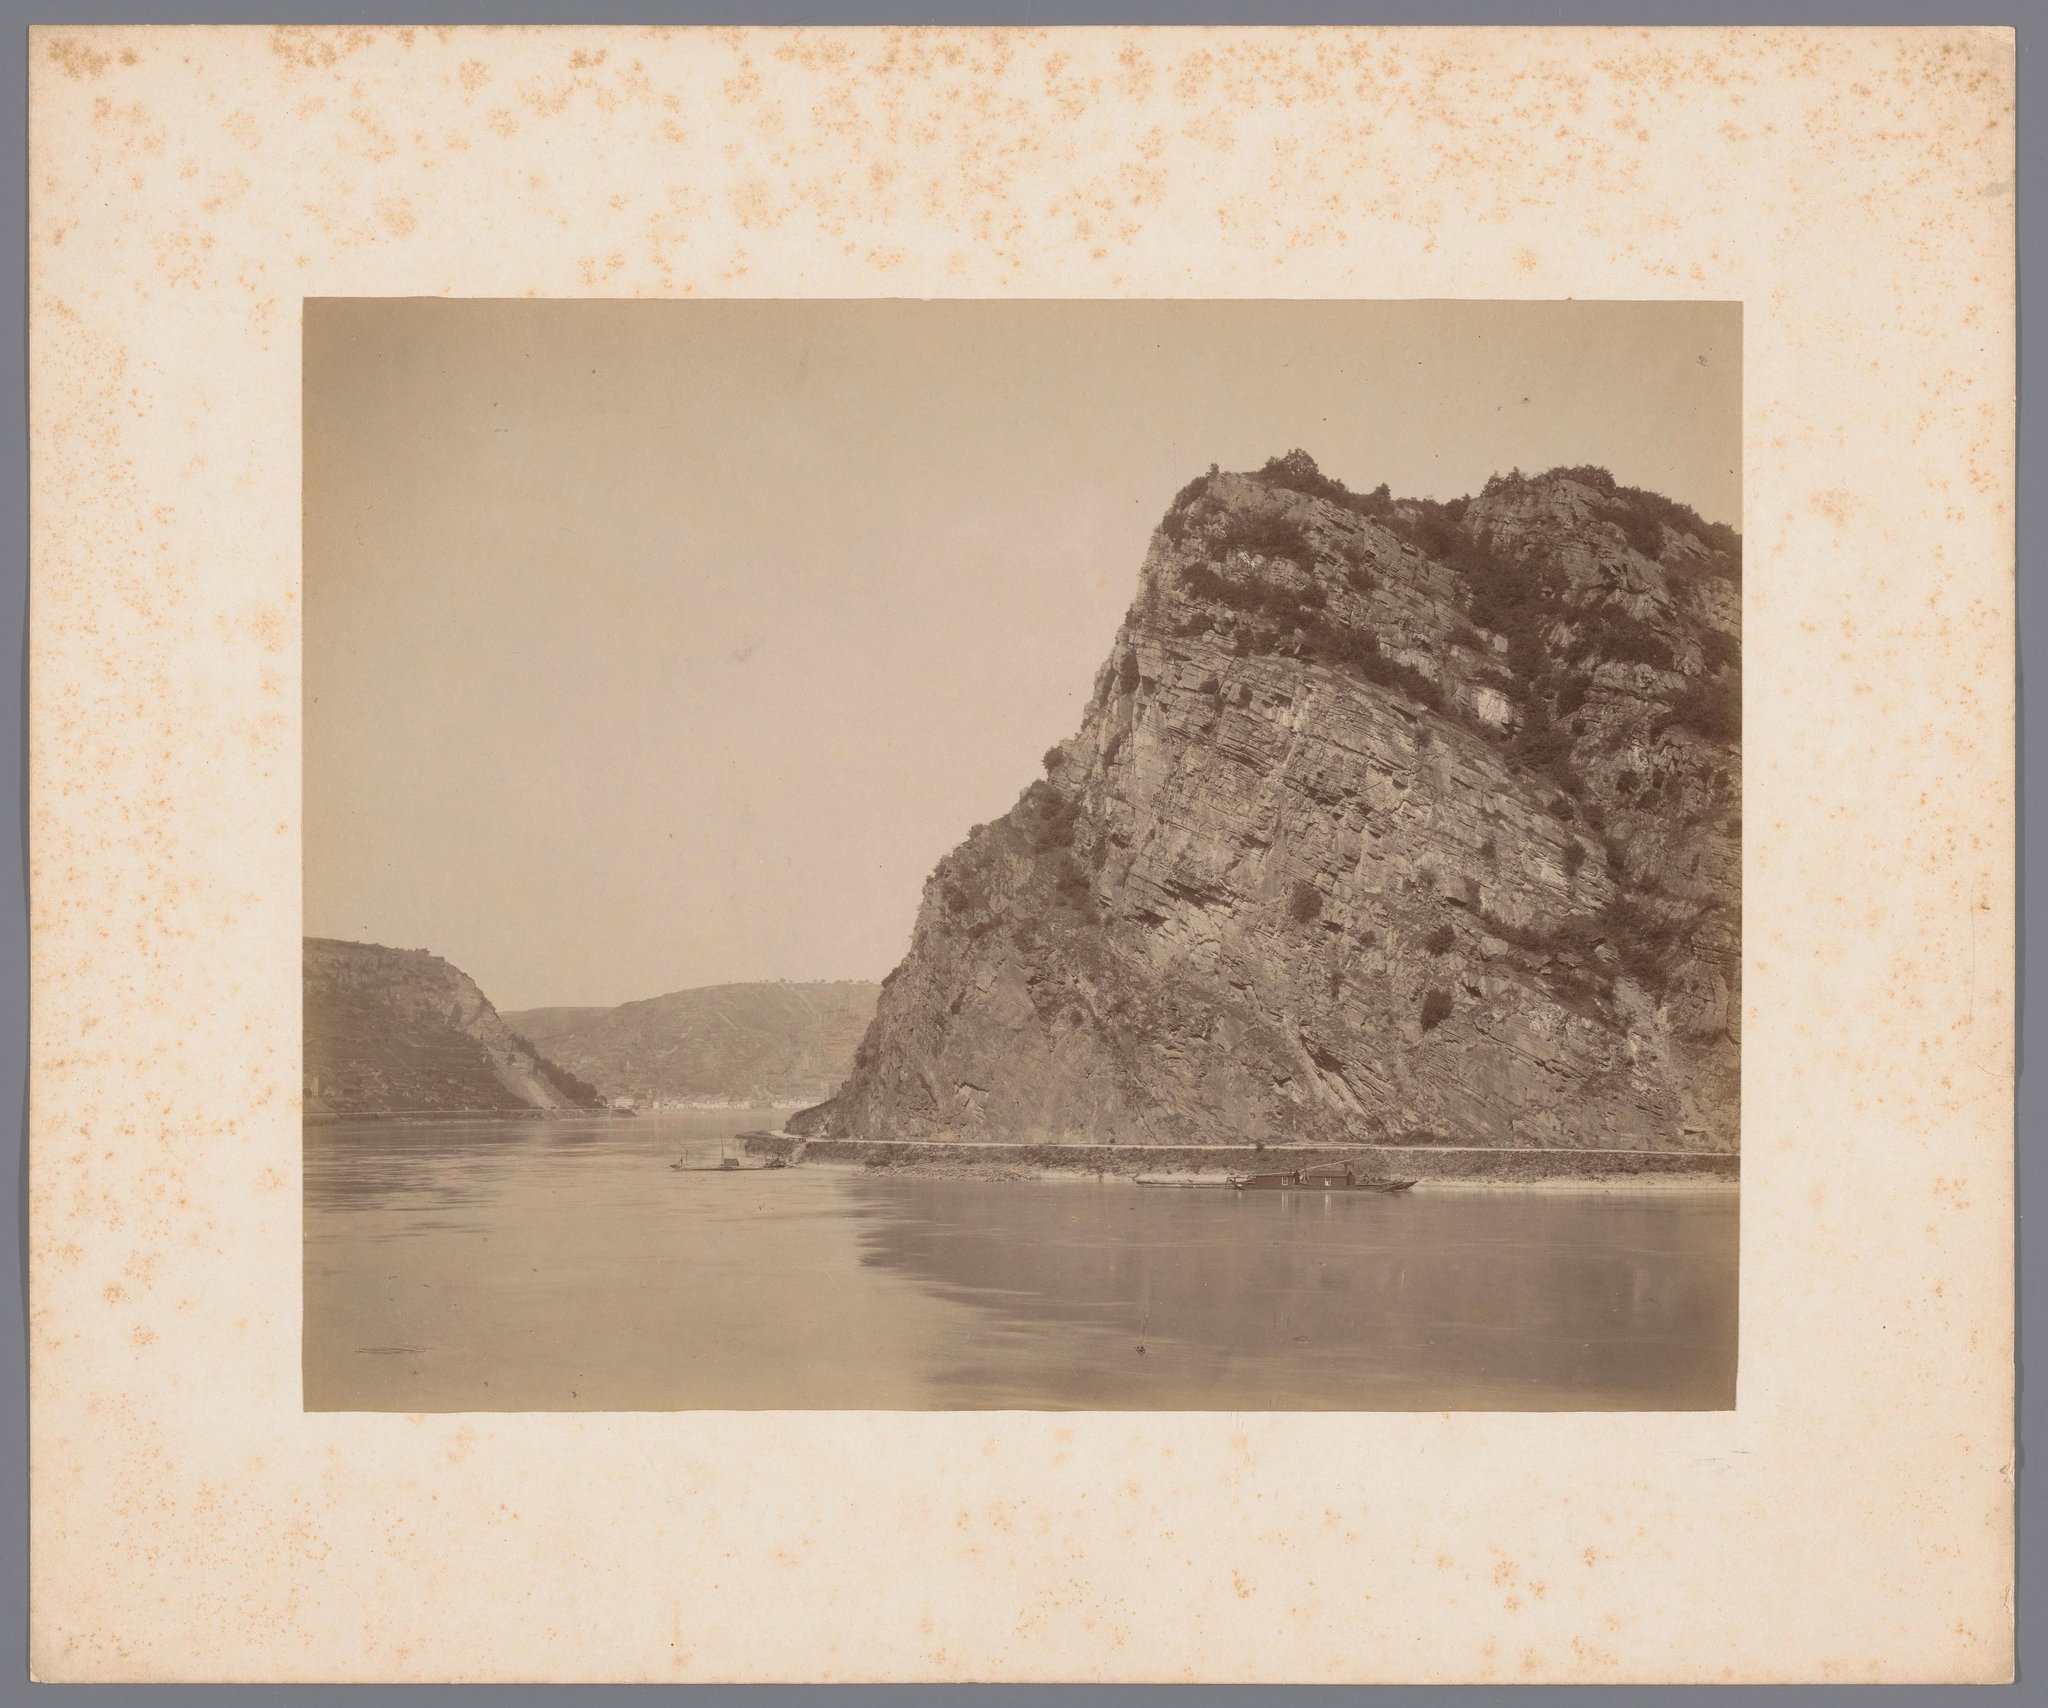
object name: photograph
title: Rots van de Loreley aan de Rijn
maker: Anonymous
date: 1883-1900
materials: cardboard, paper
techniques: albumen print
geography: loreley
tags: river, rock-formations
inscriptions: inscription: ‘23 Dinsdag 28 Juli/ Lorlei/ 23’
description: Deze foto maakt deel uit van een fotoserie, gemaakt of gekocht door een Nederlandse reiziger die onderweg was in Duitsland, Oostenrijk en Italië tussen 27 juni en 29 juli. Het jaartal van de reis is onbekend, maar de foto's zijn waarschijnlijk gemaakt tussen 1883 en 1900.